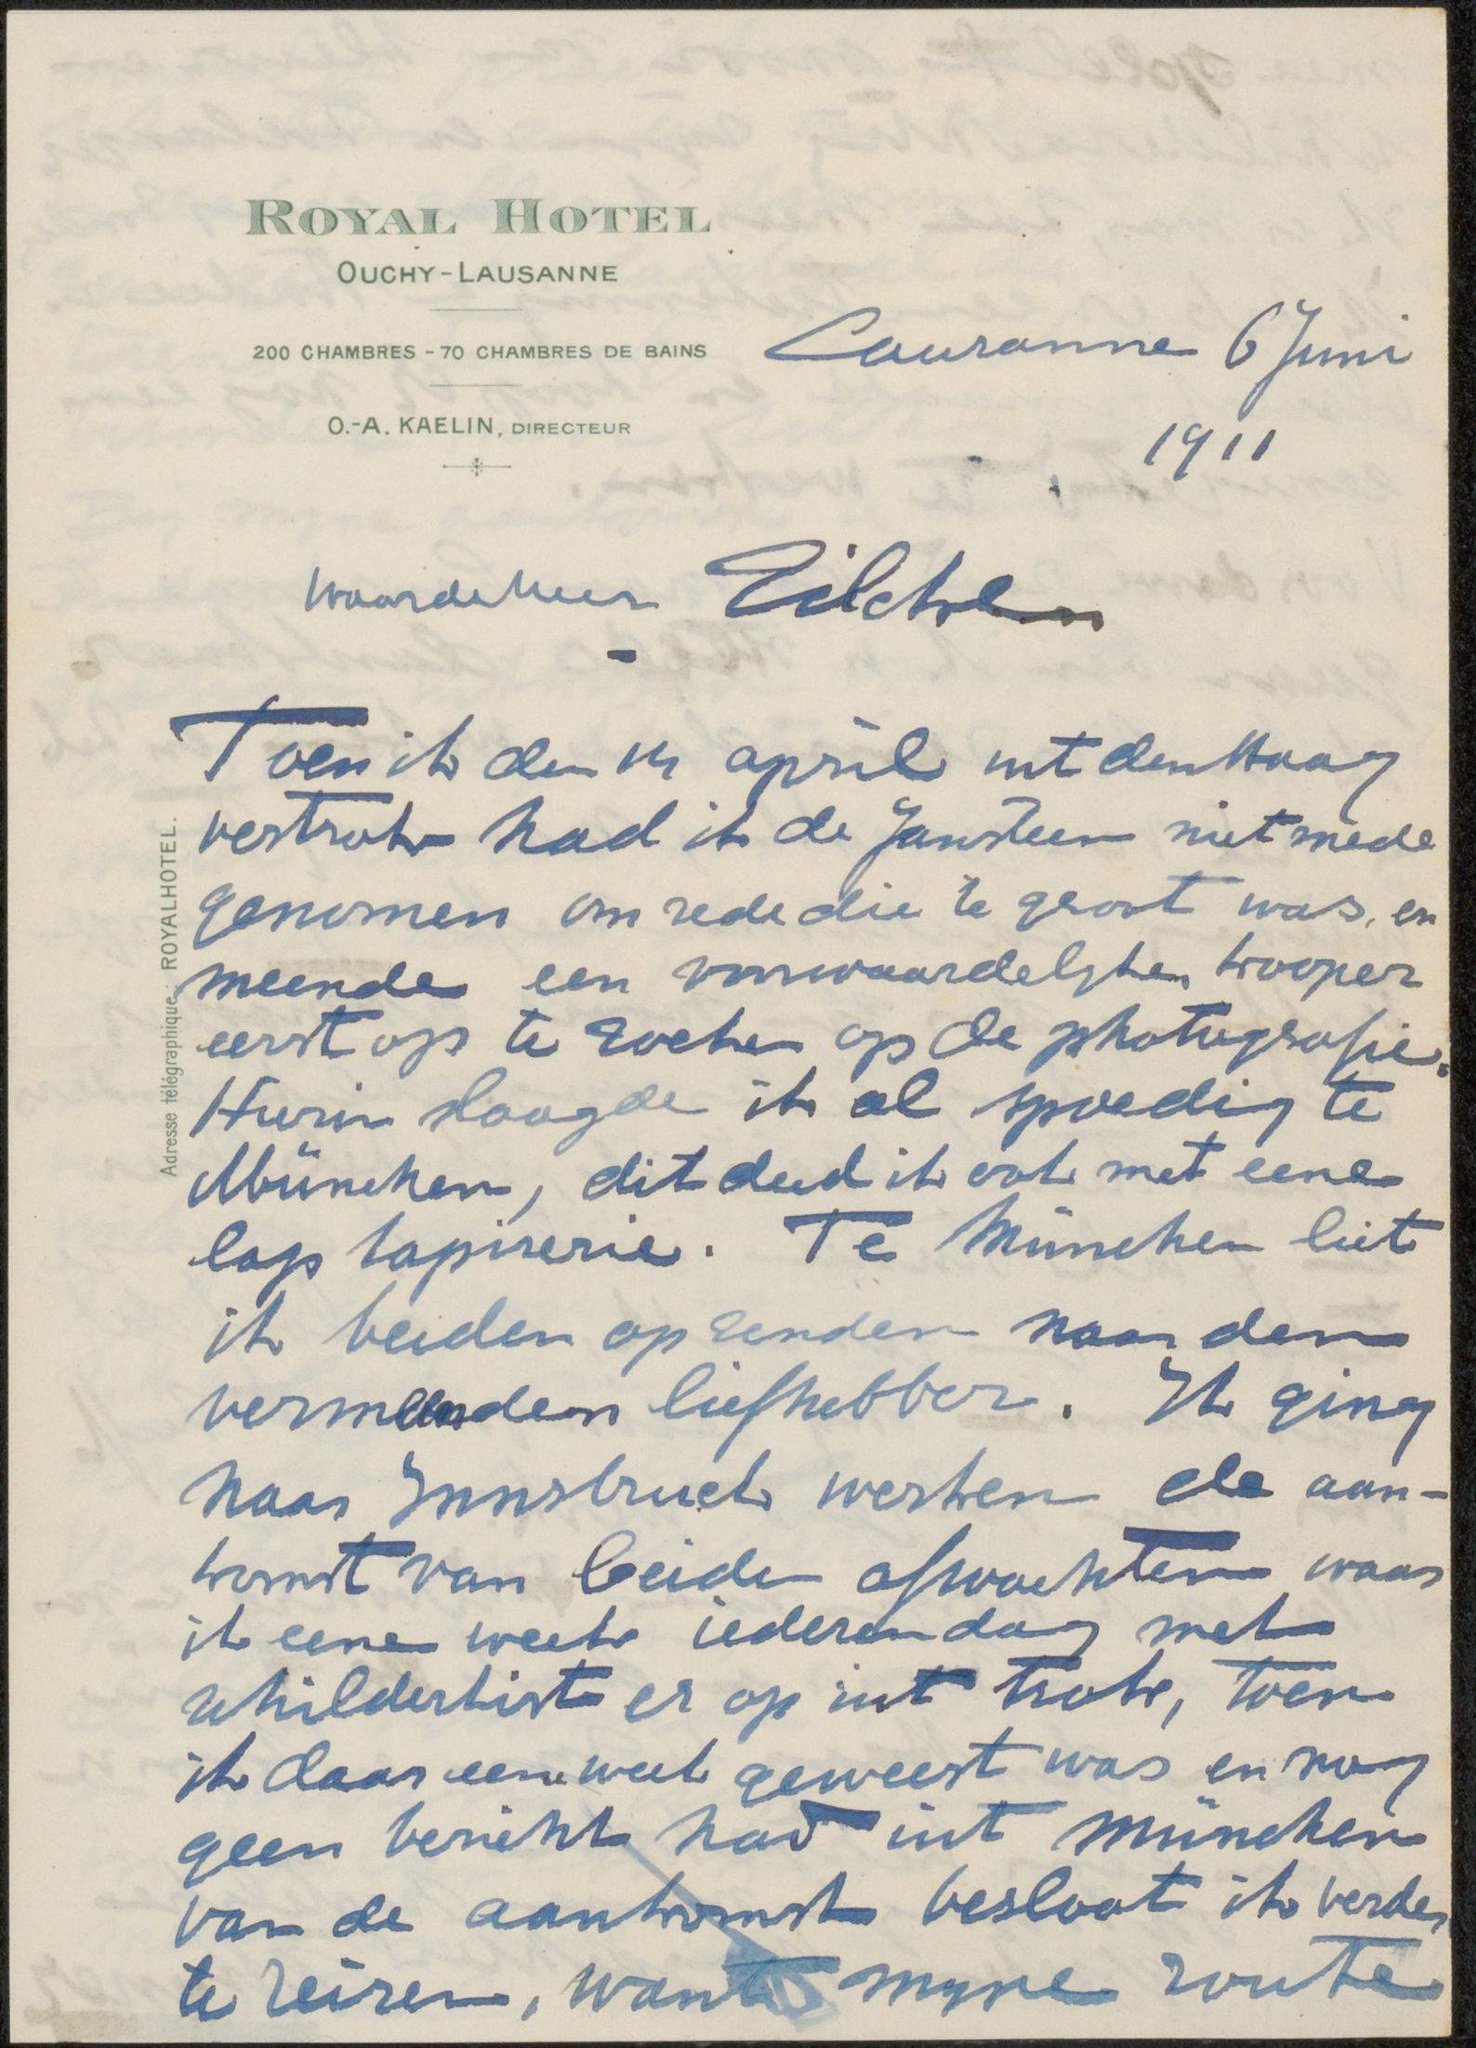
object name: letter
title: Brief aan Philip Zilcken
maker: arend hijner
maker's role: draughtsman, painter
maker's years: 1866-1916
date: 1911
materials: ink, paper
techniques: pen, writing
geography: lausanne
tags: leiden, painter, print maker, jan havicksz. steen, draughtsman, philip zilcken, art trade, art shop, drawing, travelling; tourism, painting (including book-illumination, miniature-painting), artist at work, in his workshop - bb - out of doors, venice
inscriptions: collector's mark: ‘RPK’